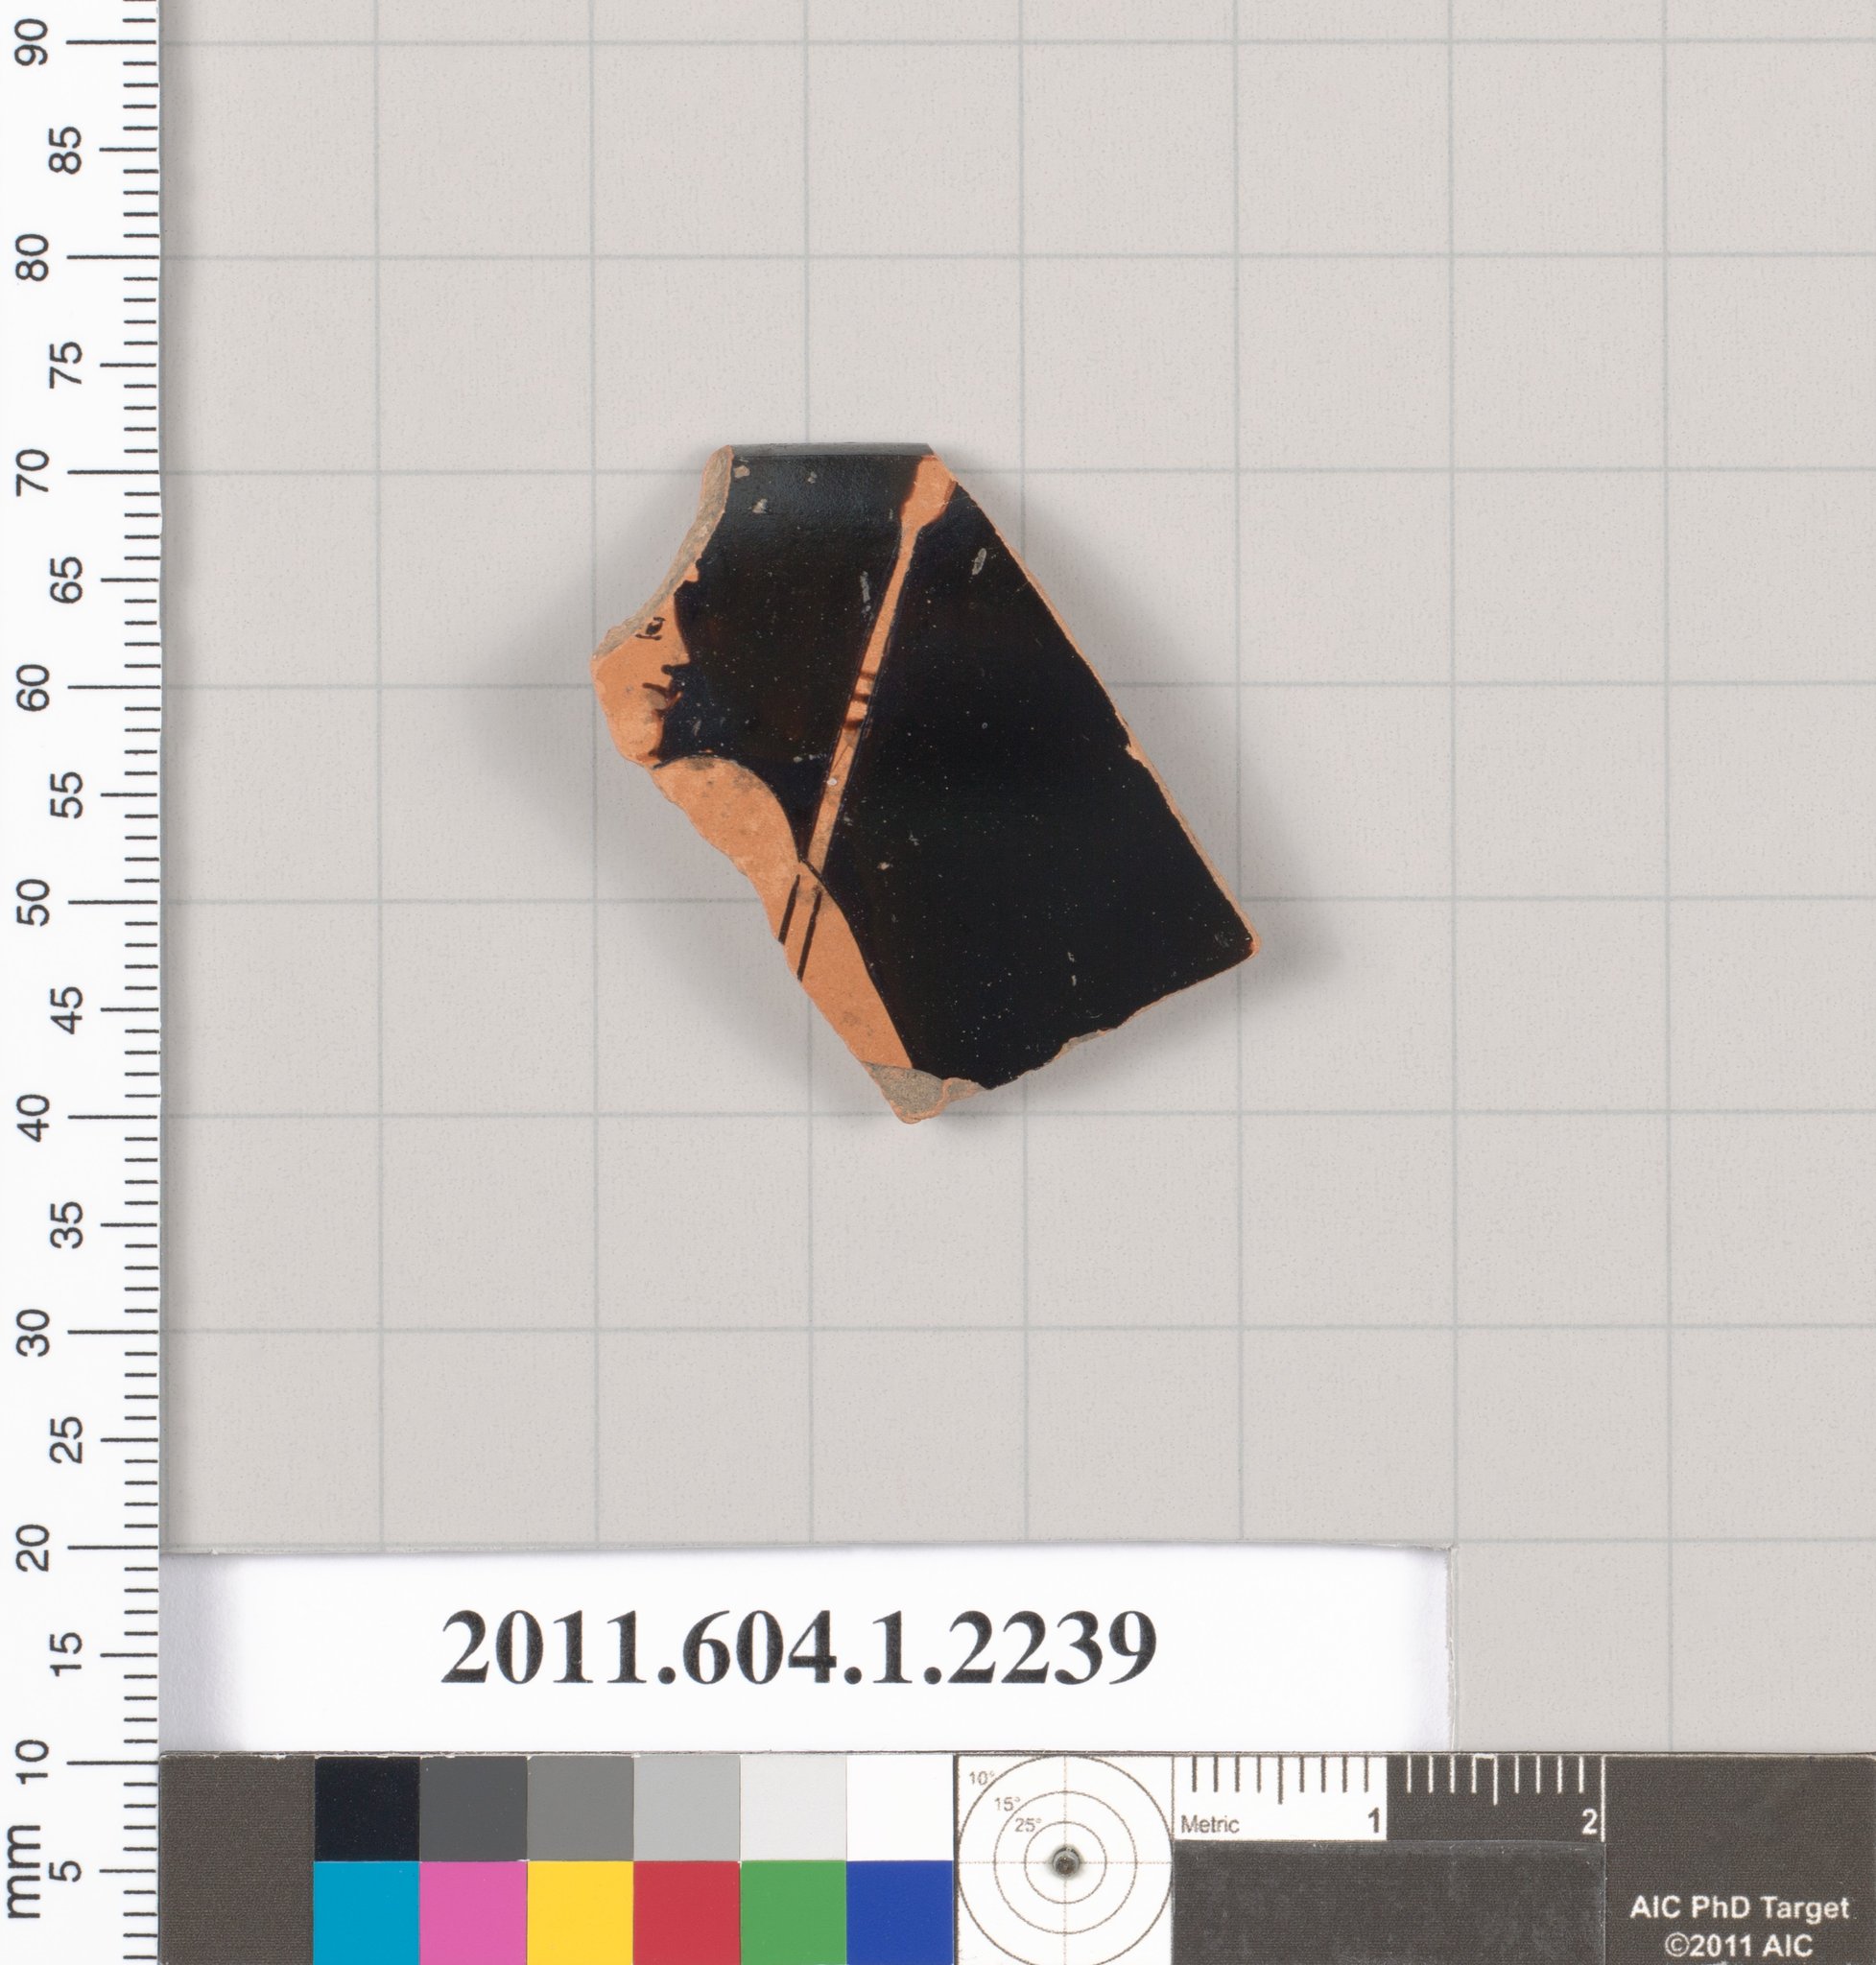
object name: kylix fragment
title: Terracotta rim fragment of a kylix (drinking cup)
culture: greek, attic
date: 475-451 BCE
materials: terracotta